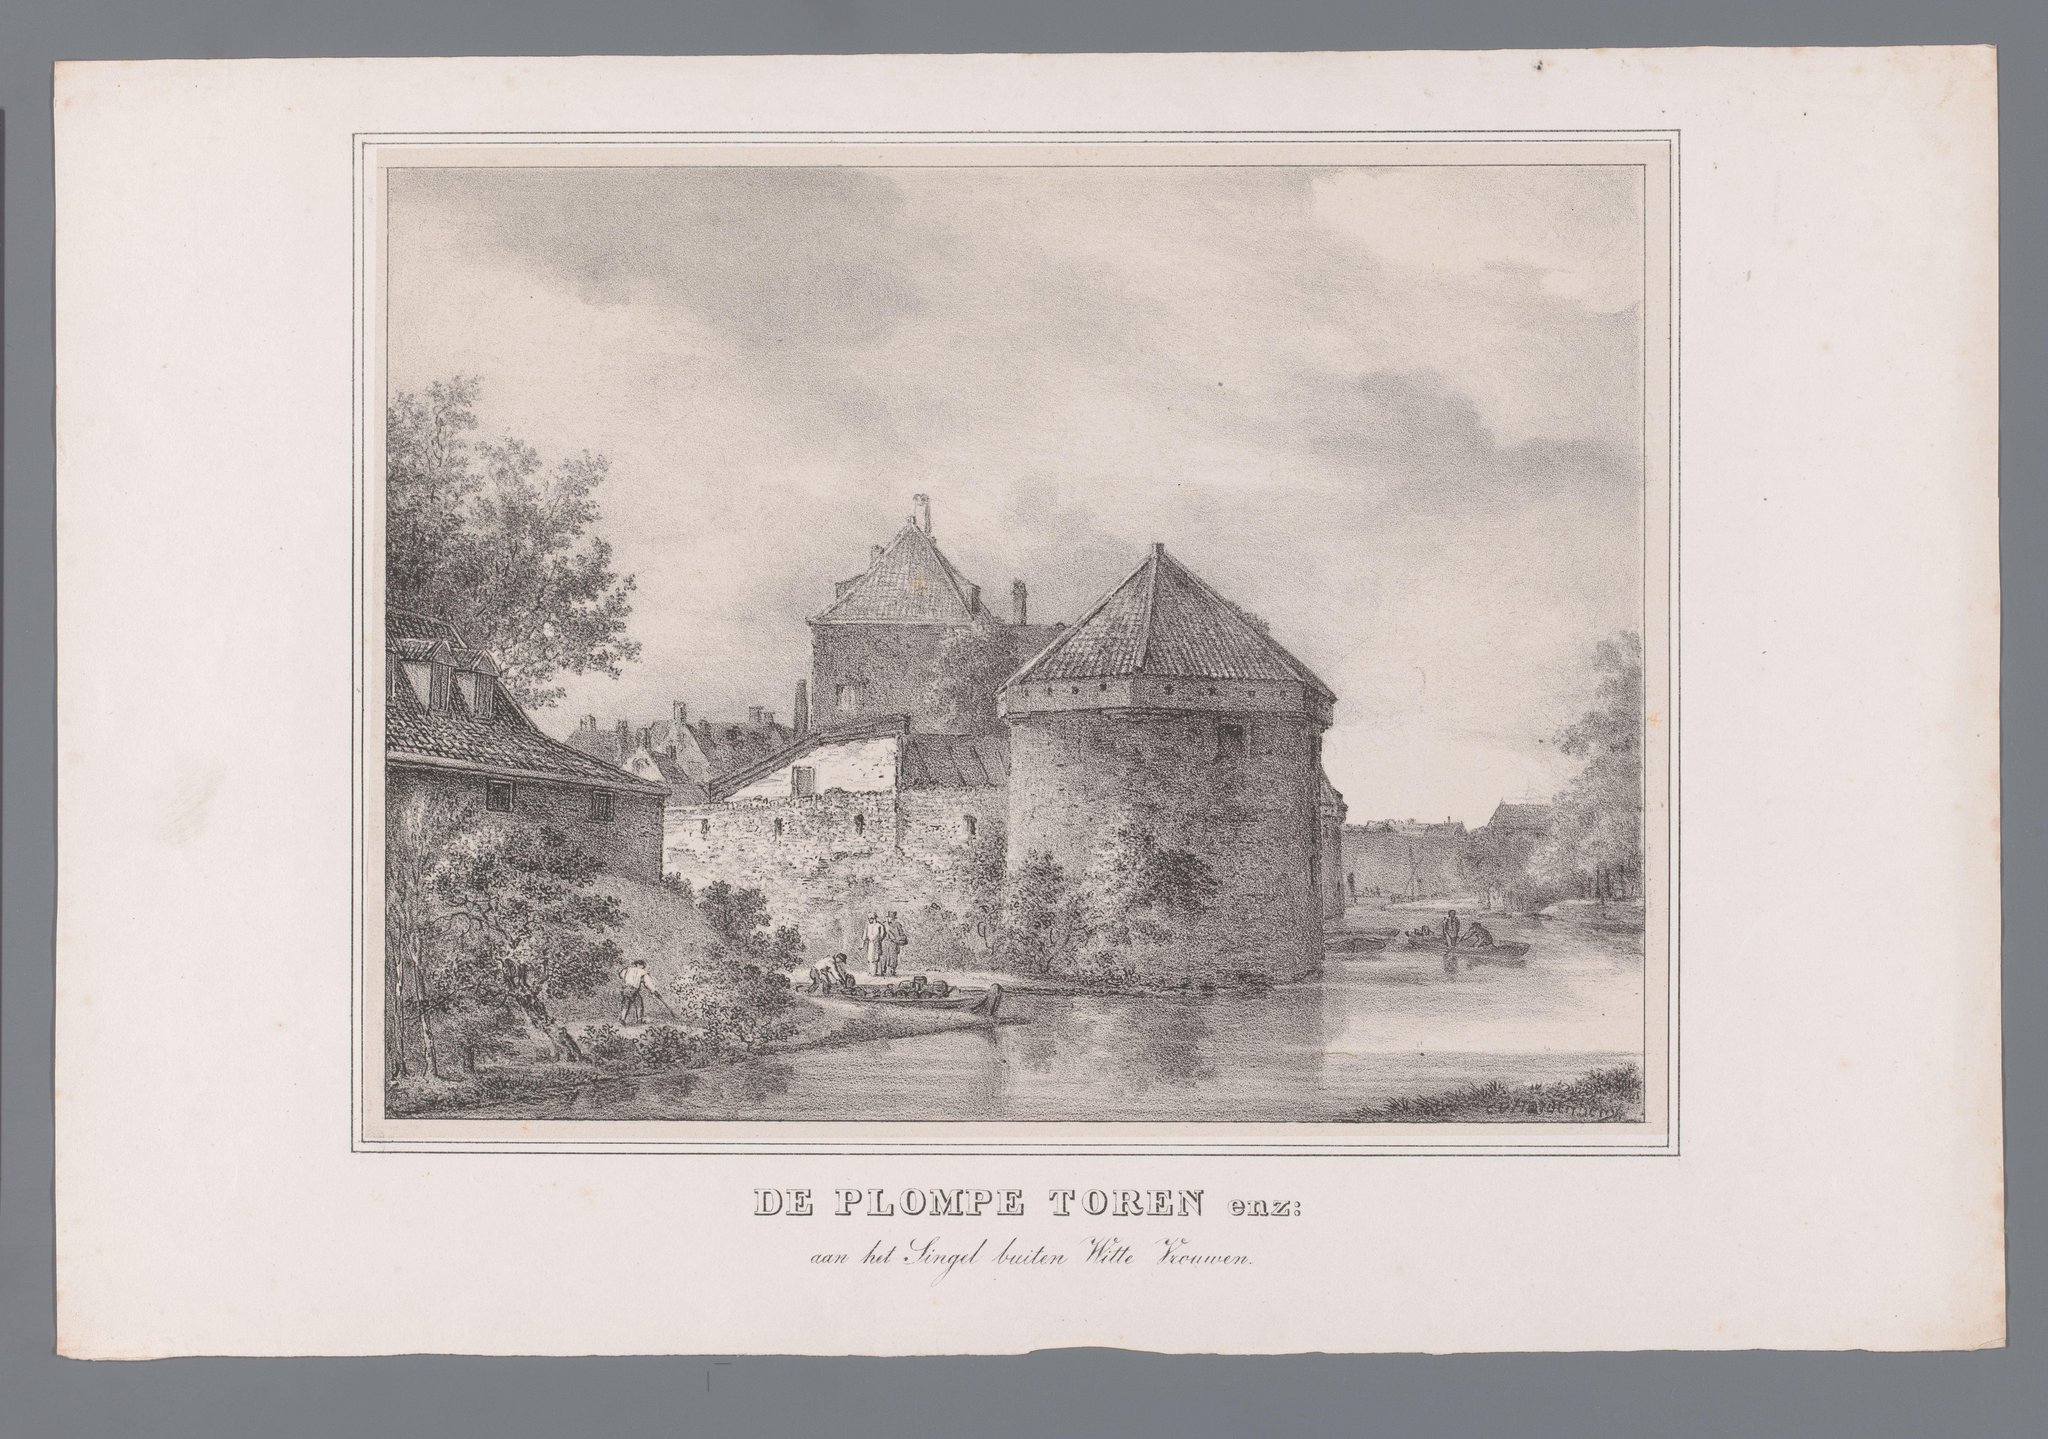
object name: print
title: Afbeeldingen van gezichten te of bij Utrecht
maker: cornelis van hardenbergh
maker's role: draughtsman, painter, print maker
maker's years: 1755-1843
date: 1809-1843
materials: paper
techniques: lithograph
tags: towers ~ fortified city, utrecht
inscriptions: collector's mark: Lugt 2228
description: Maakt deel uit van een omslag met negen prenten.